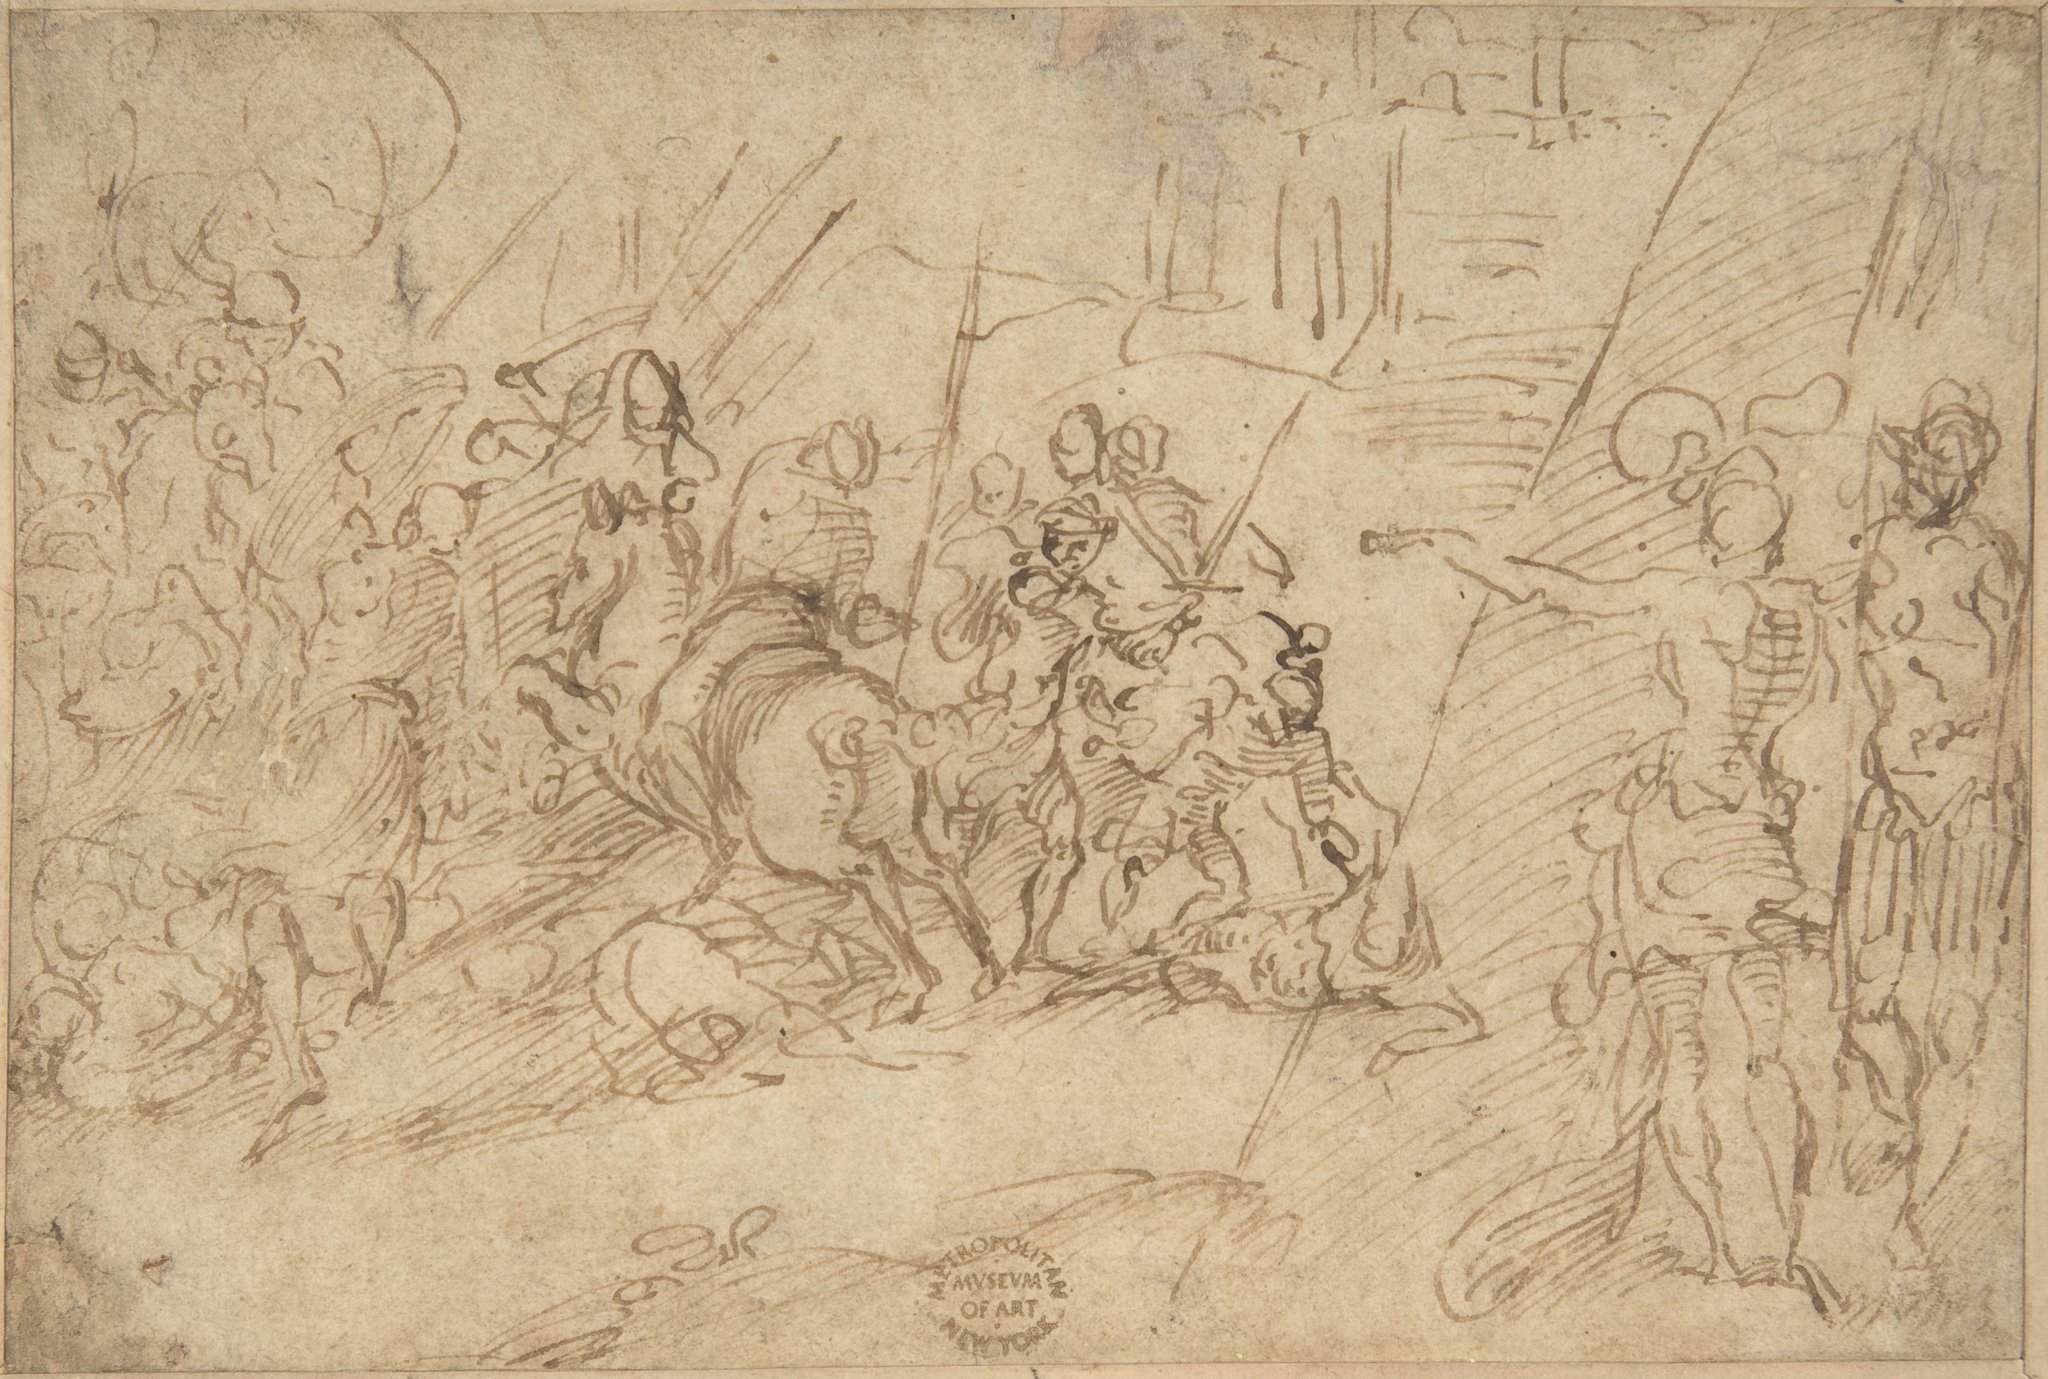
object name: drawing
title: Skirmish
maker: anonymous, italian, 16th century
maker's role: artist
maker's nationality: italian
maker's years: 1550-1600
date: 1501-1600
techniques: pen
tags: battles,soldiers,horses